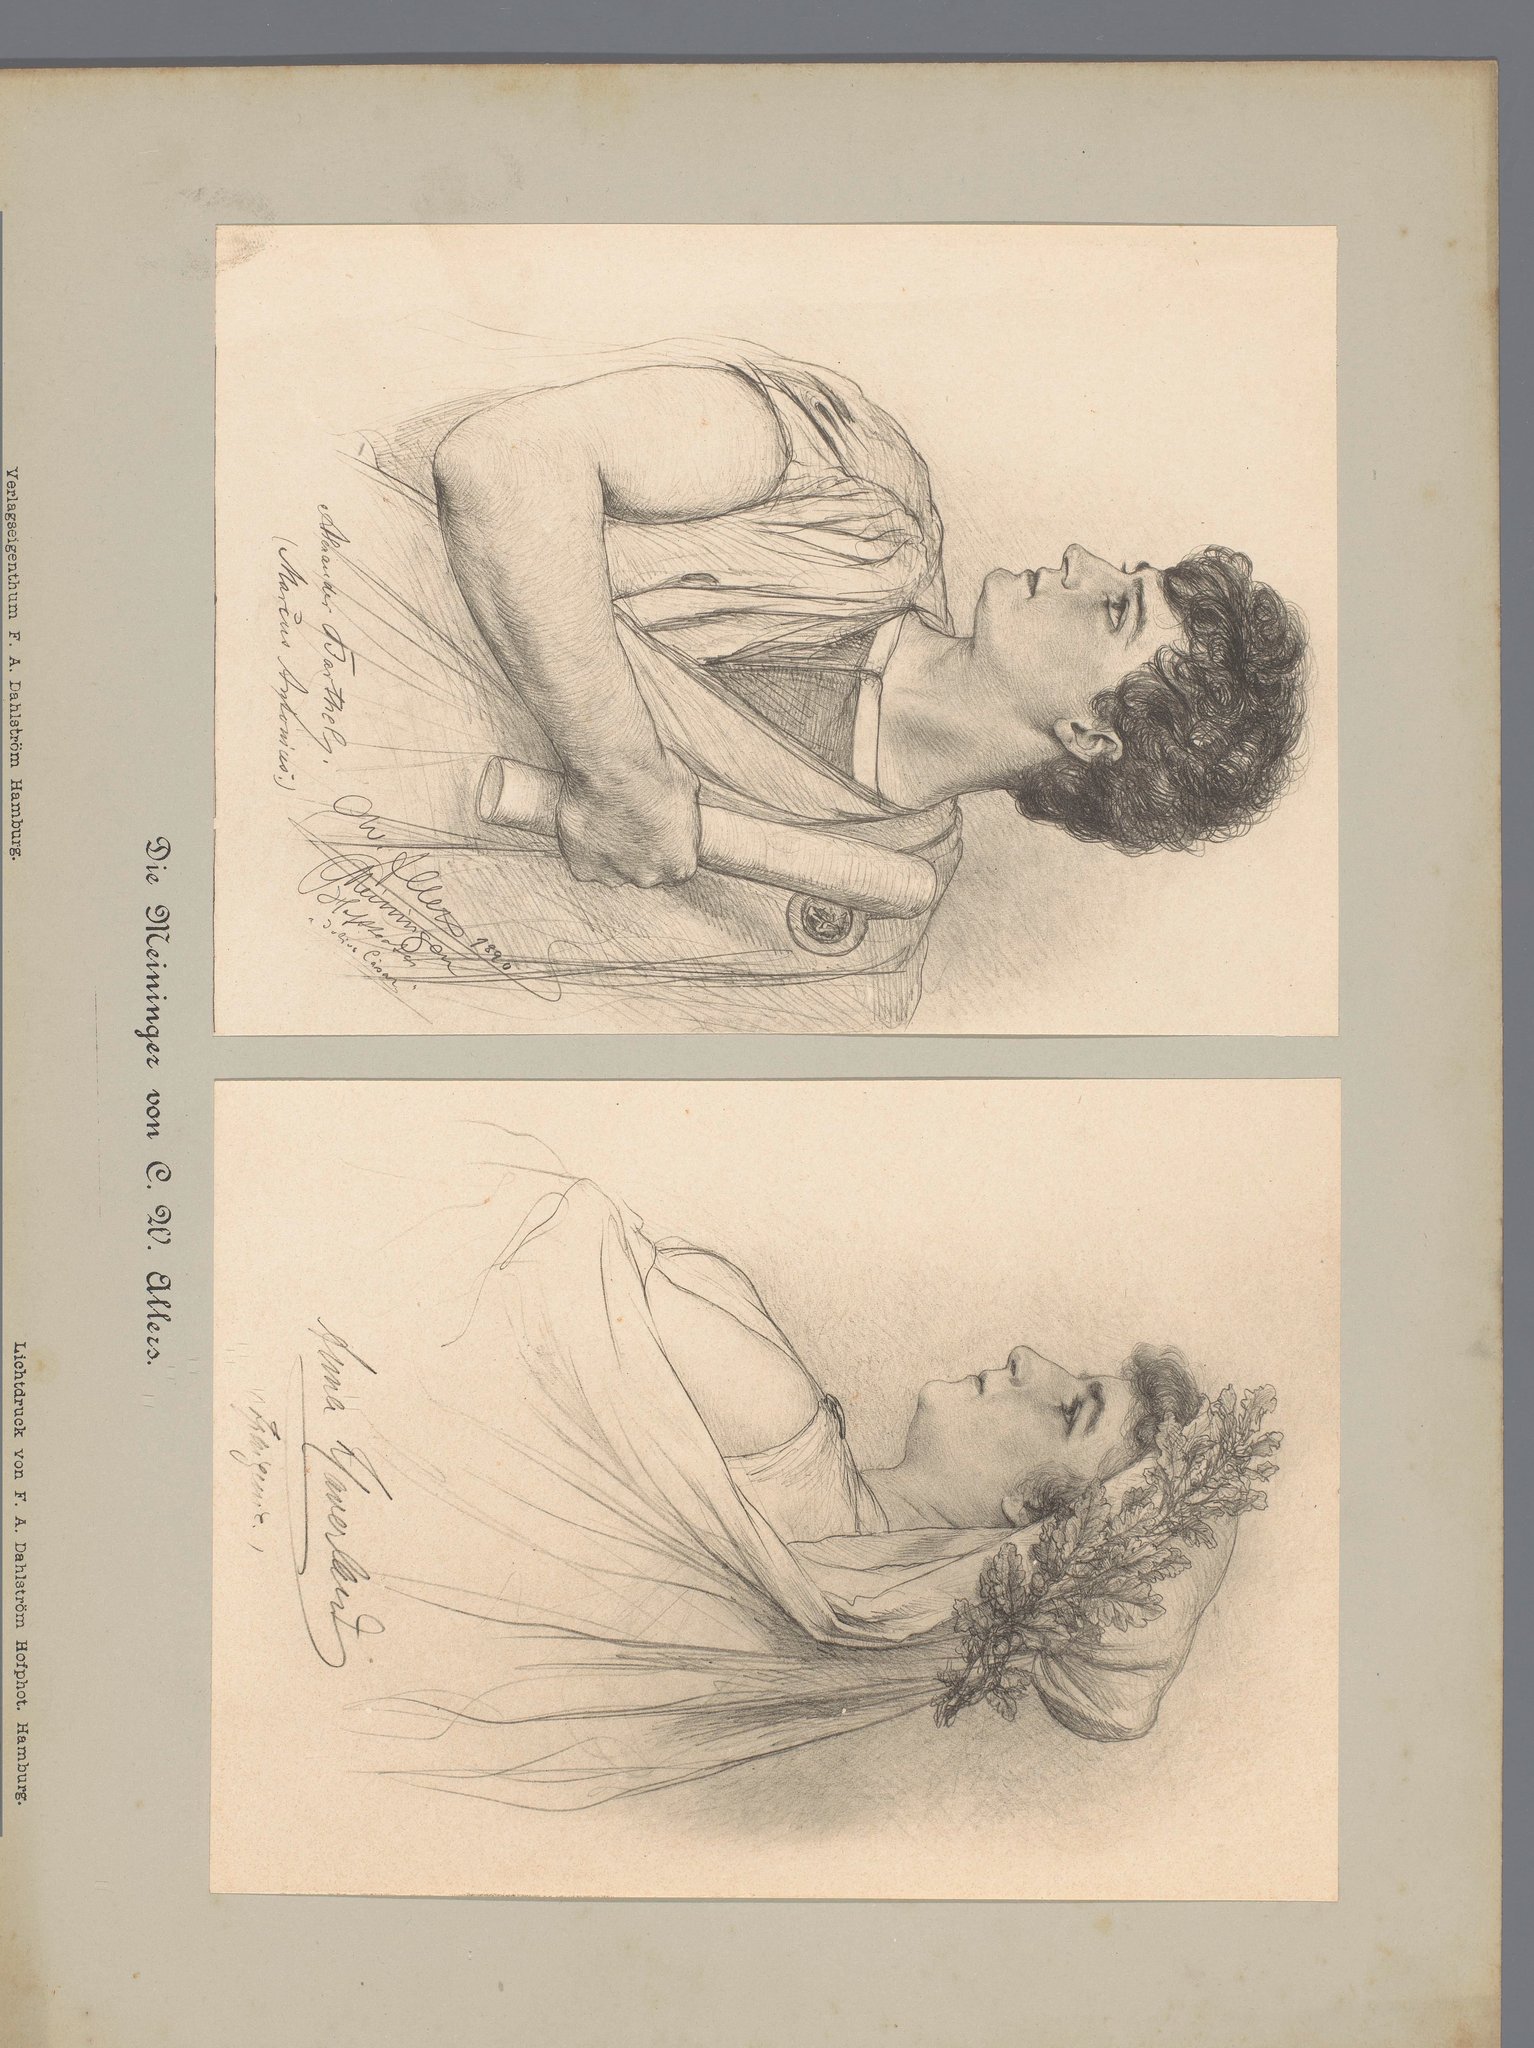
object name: reproduction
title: Die Meininger von C. W. Allers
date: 1890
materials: paper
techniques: photograph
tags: iphigenia, portrait of actor, actress